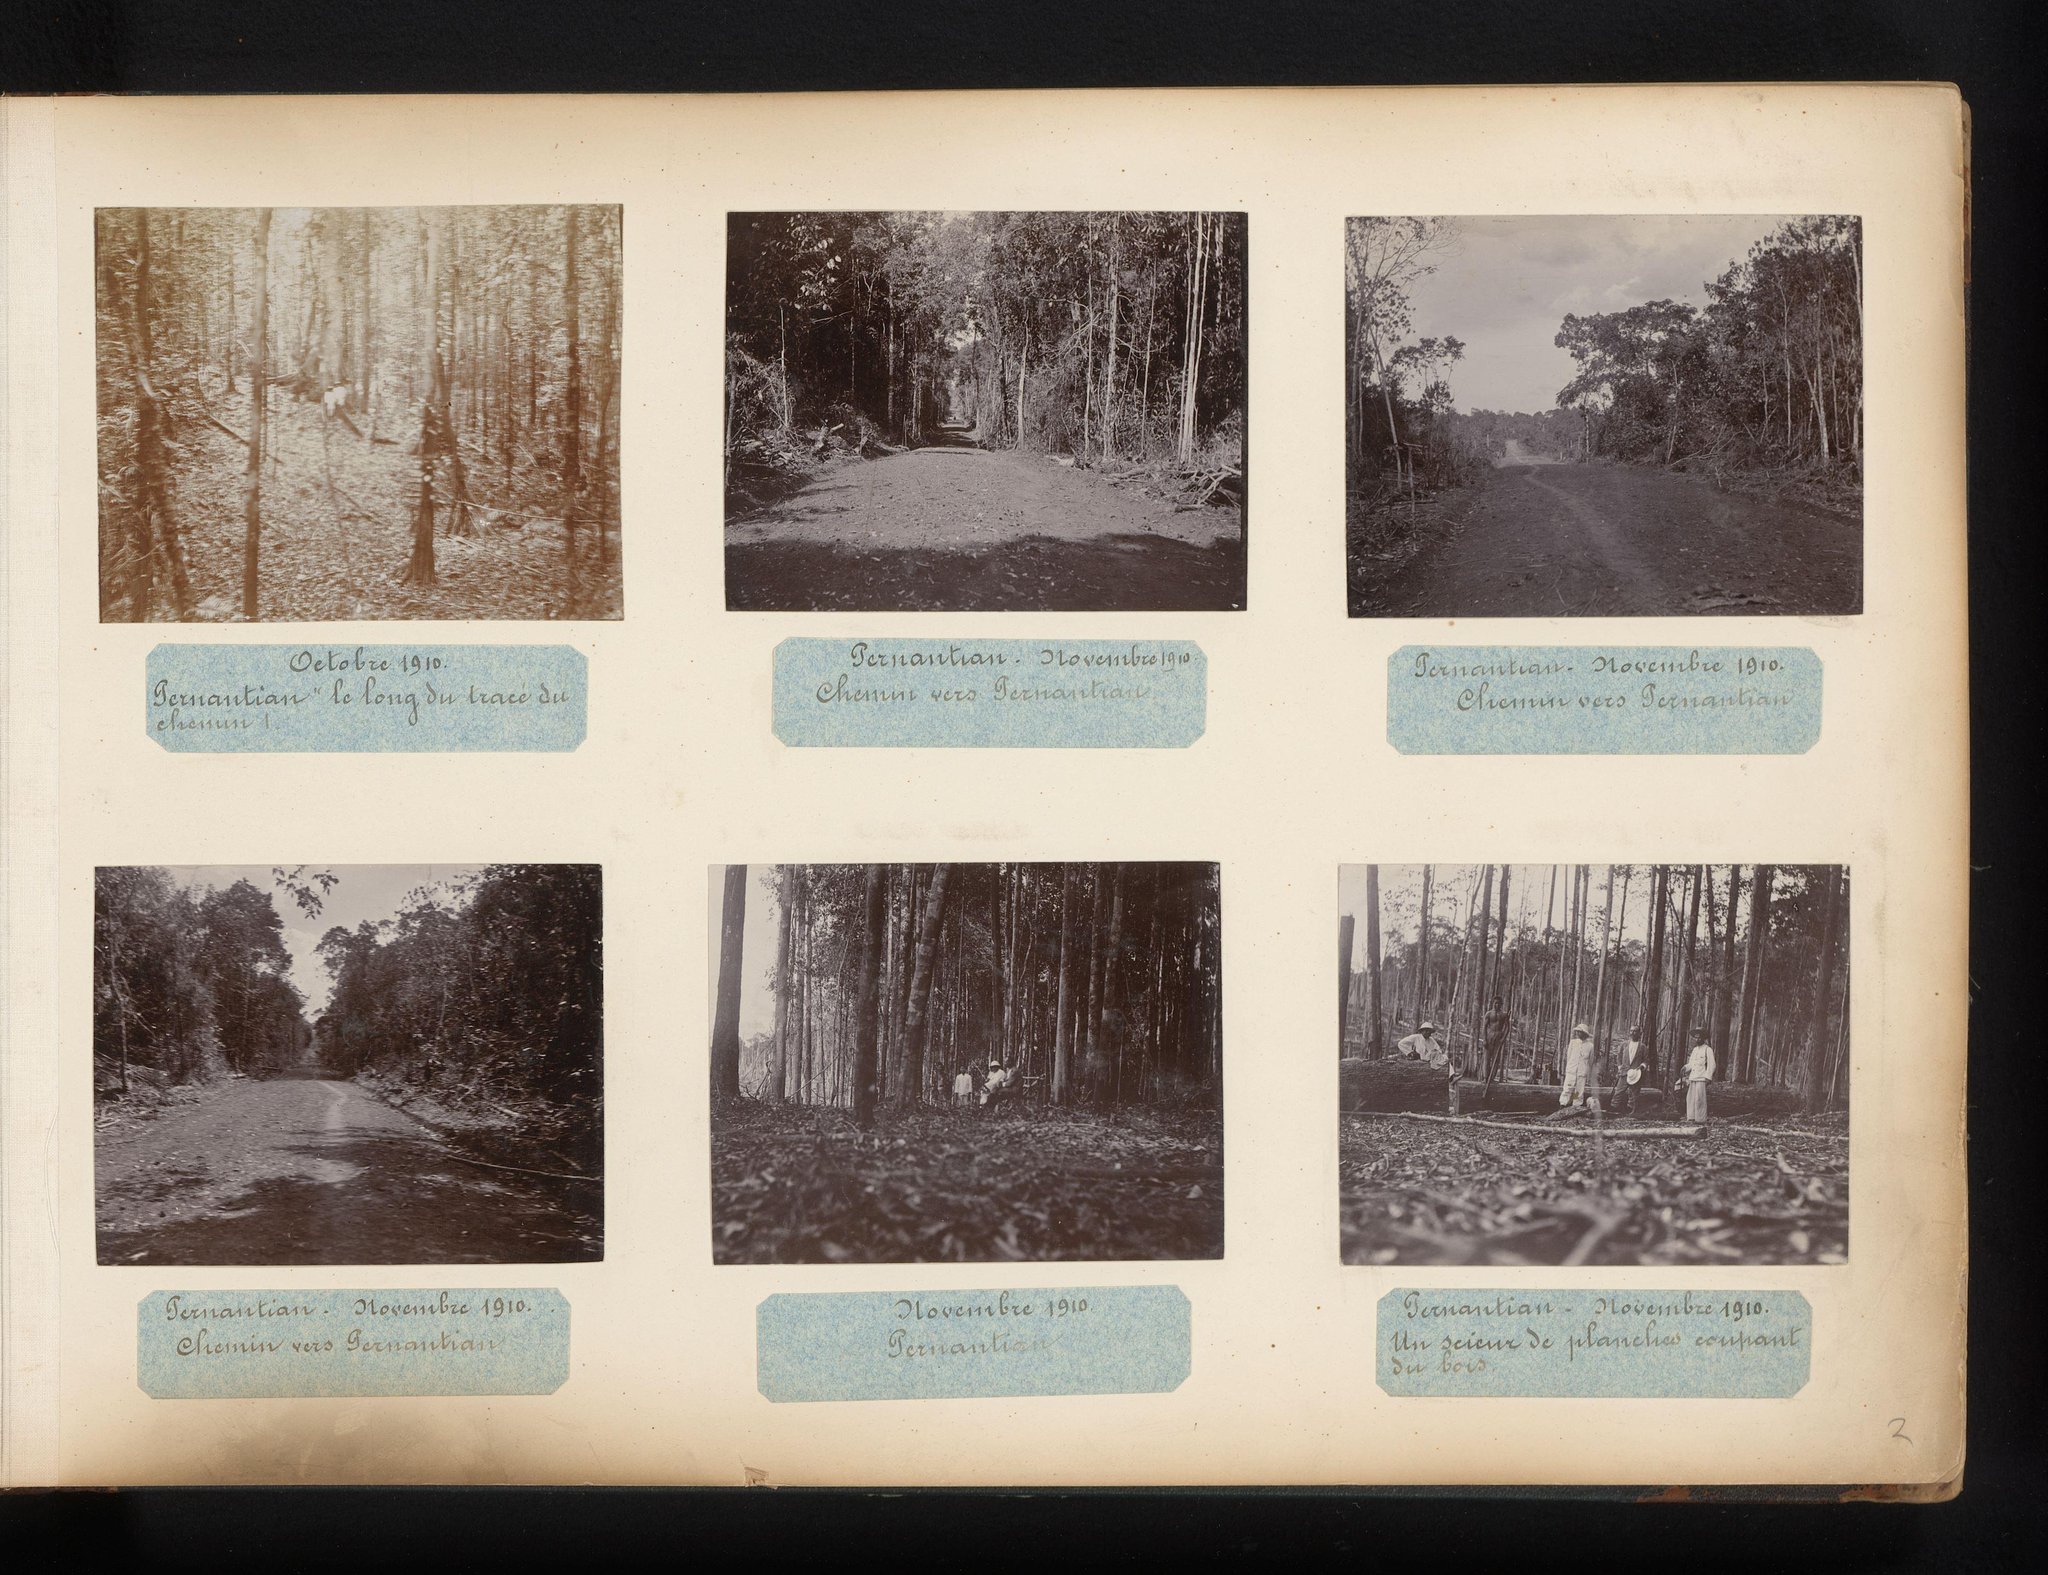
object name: photograph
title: Aanleg van weg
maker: Anonymous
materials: cardboard, photographic support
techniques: collodion silver print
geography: east sumatra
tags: plantation, (non-fruit) products of plants or trees: rubber, woodcutting, woodcutter ~ forestry, road, path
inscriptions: inscription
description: Blad met zes foto's van het aanleggen van een weg door het bos naar Pernantian, oktober-november 1910. Onder de foto's etiketten met onderschriften. Onderdeel van het fotoalbum over de plantages Brussel en Pernantian van de Sumatra Caoutchouc Maatschappij op de Oostkust van Sumatra in de jaren 1910-1935.